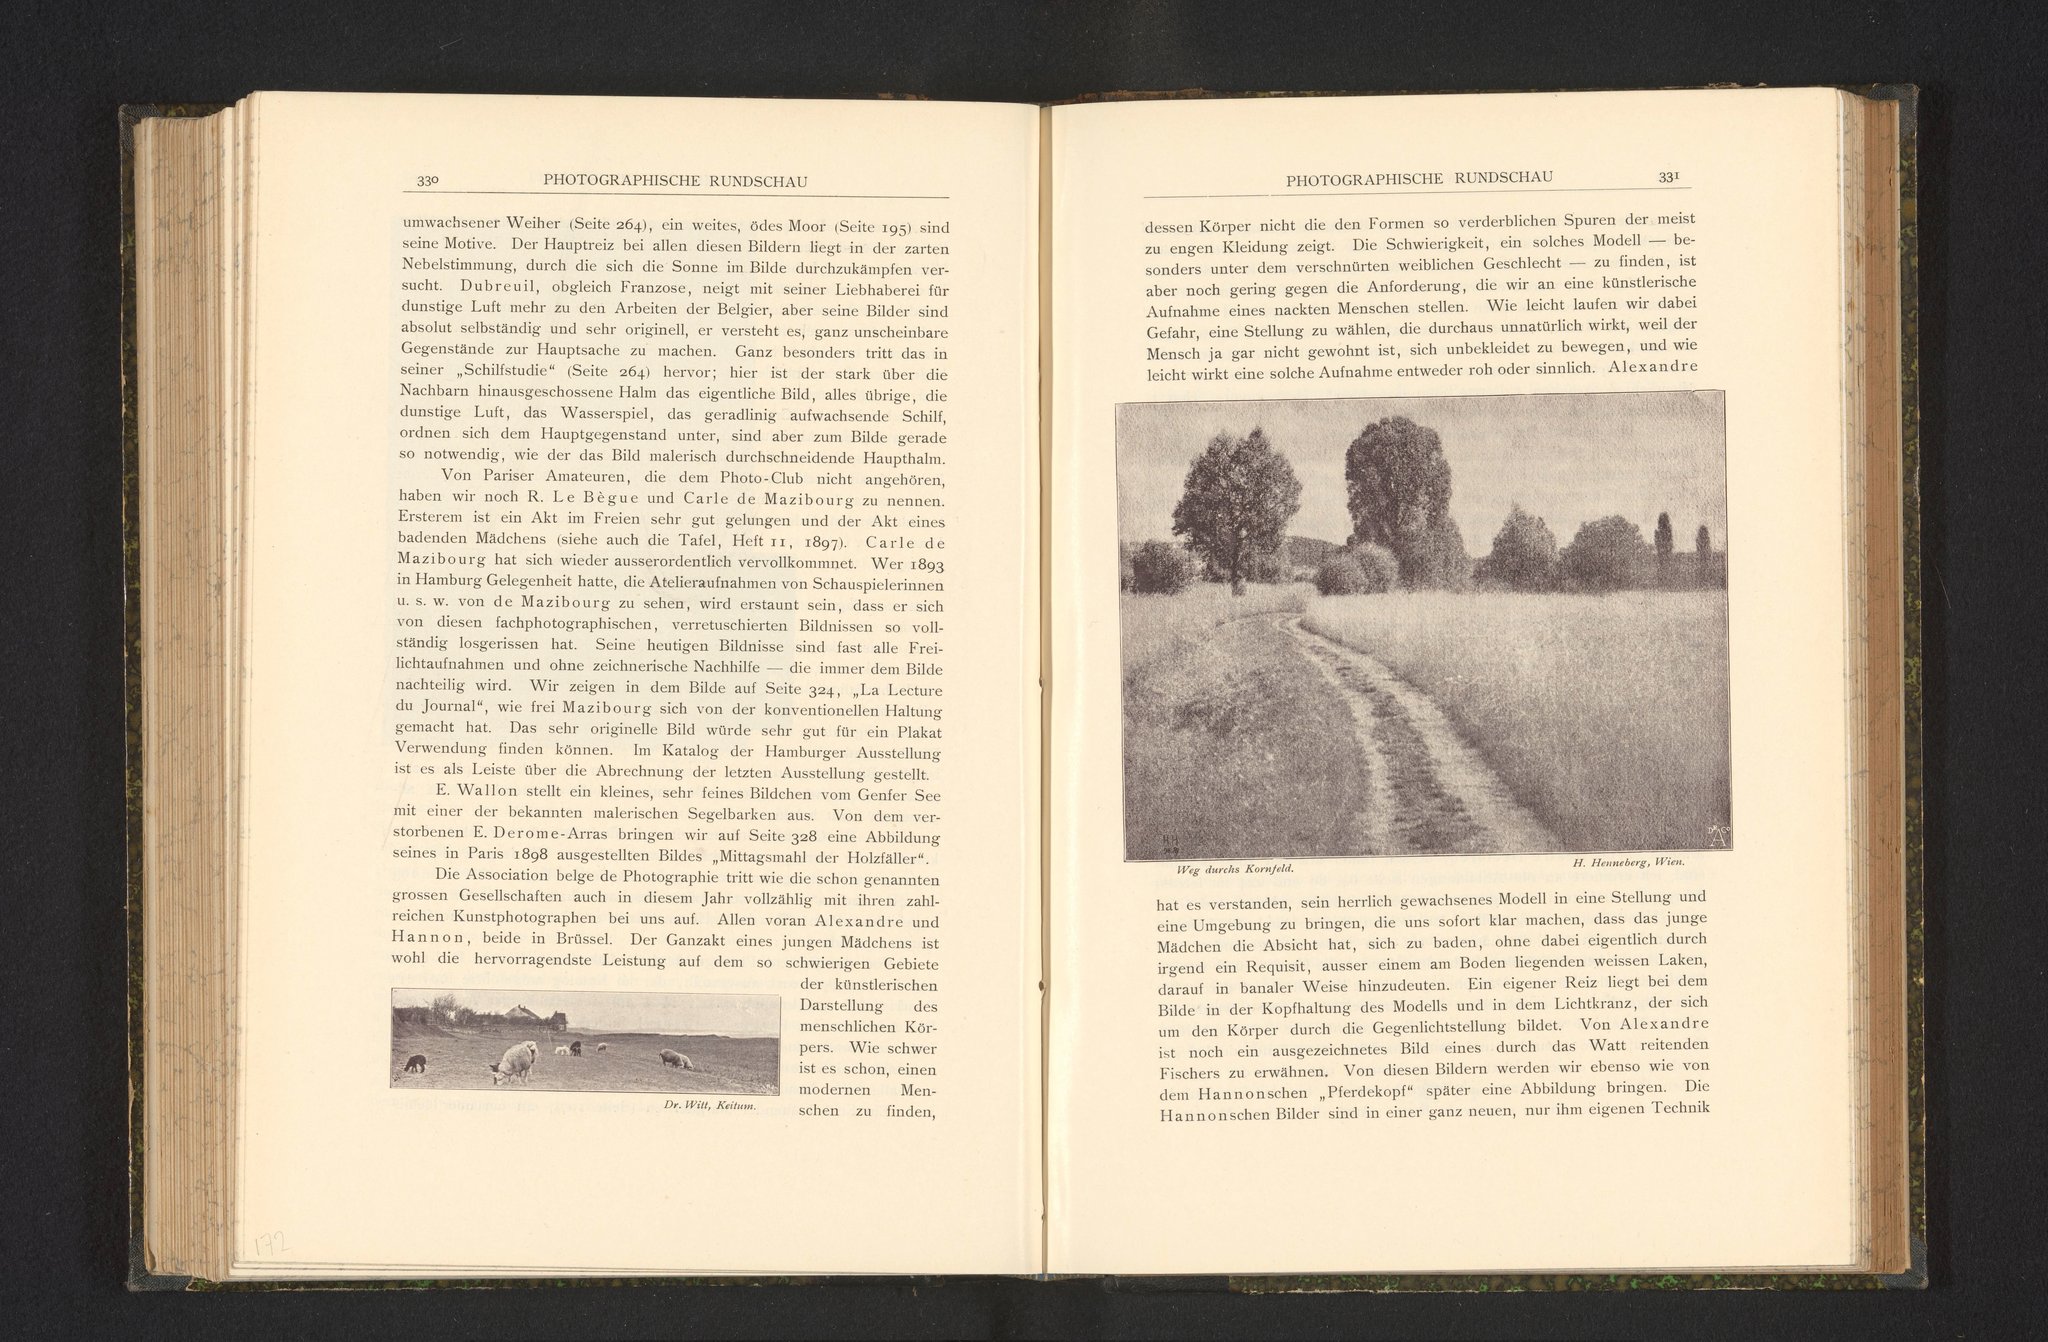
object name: photomechanical print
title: Gezicht op een weiland met schapen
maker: dr. witt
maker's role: fotograaf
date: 1893-1898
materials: paper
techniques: autotype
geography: berlin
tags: meadow, pasture, sheep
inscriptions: monogram: ‘MR&C’